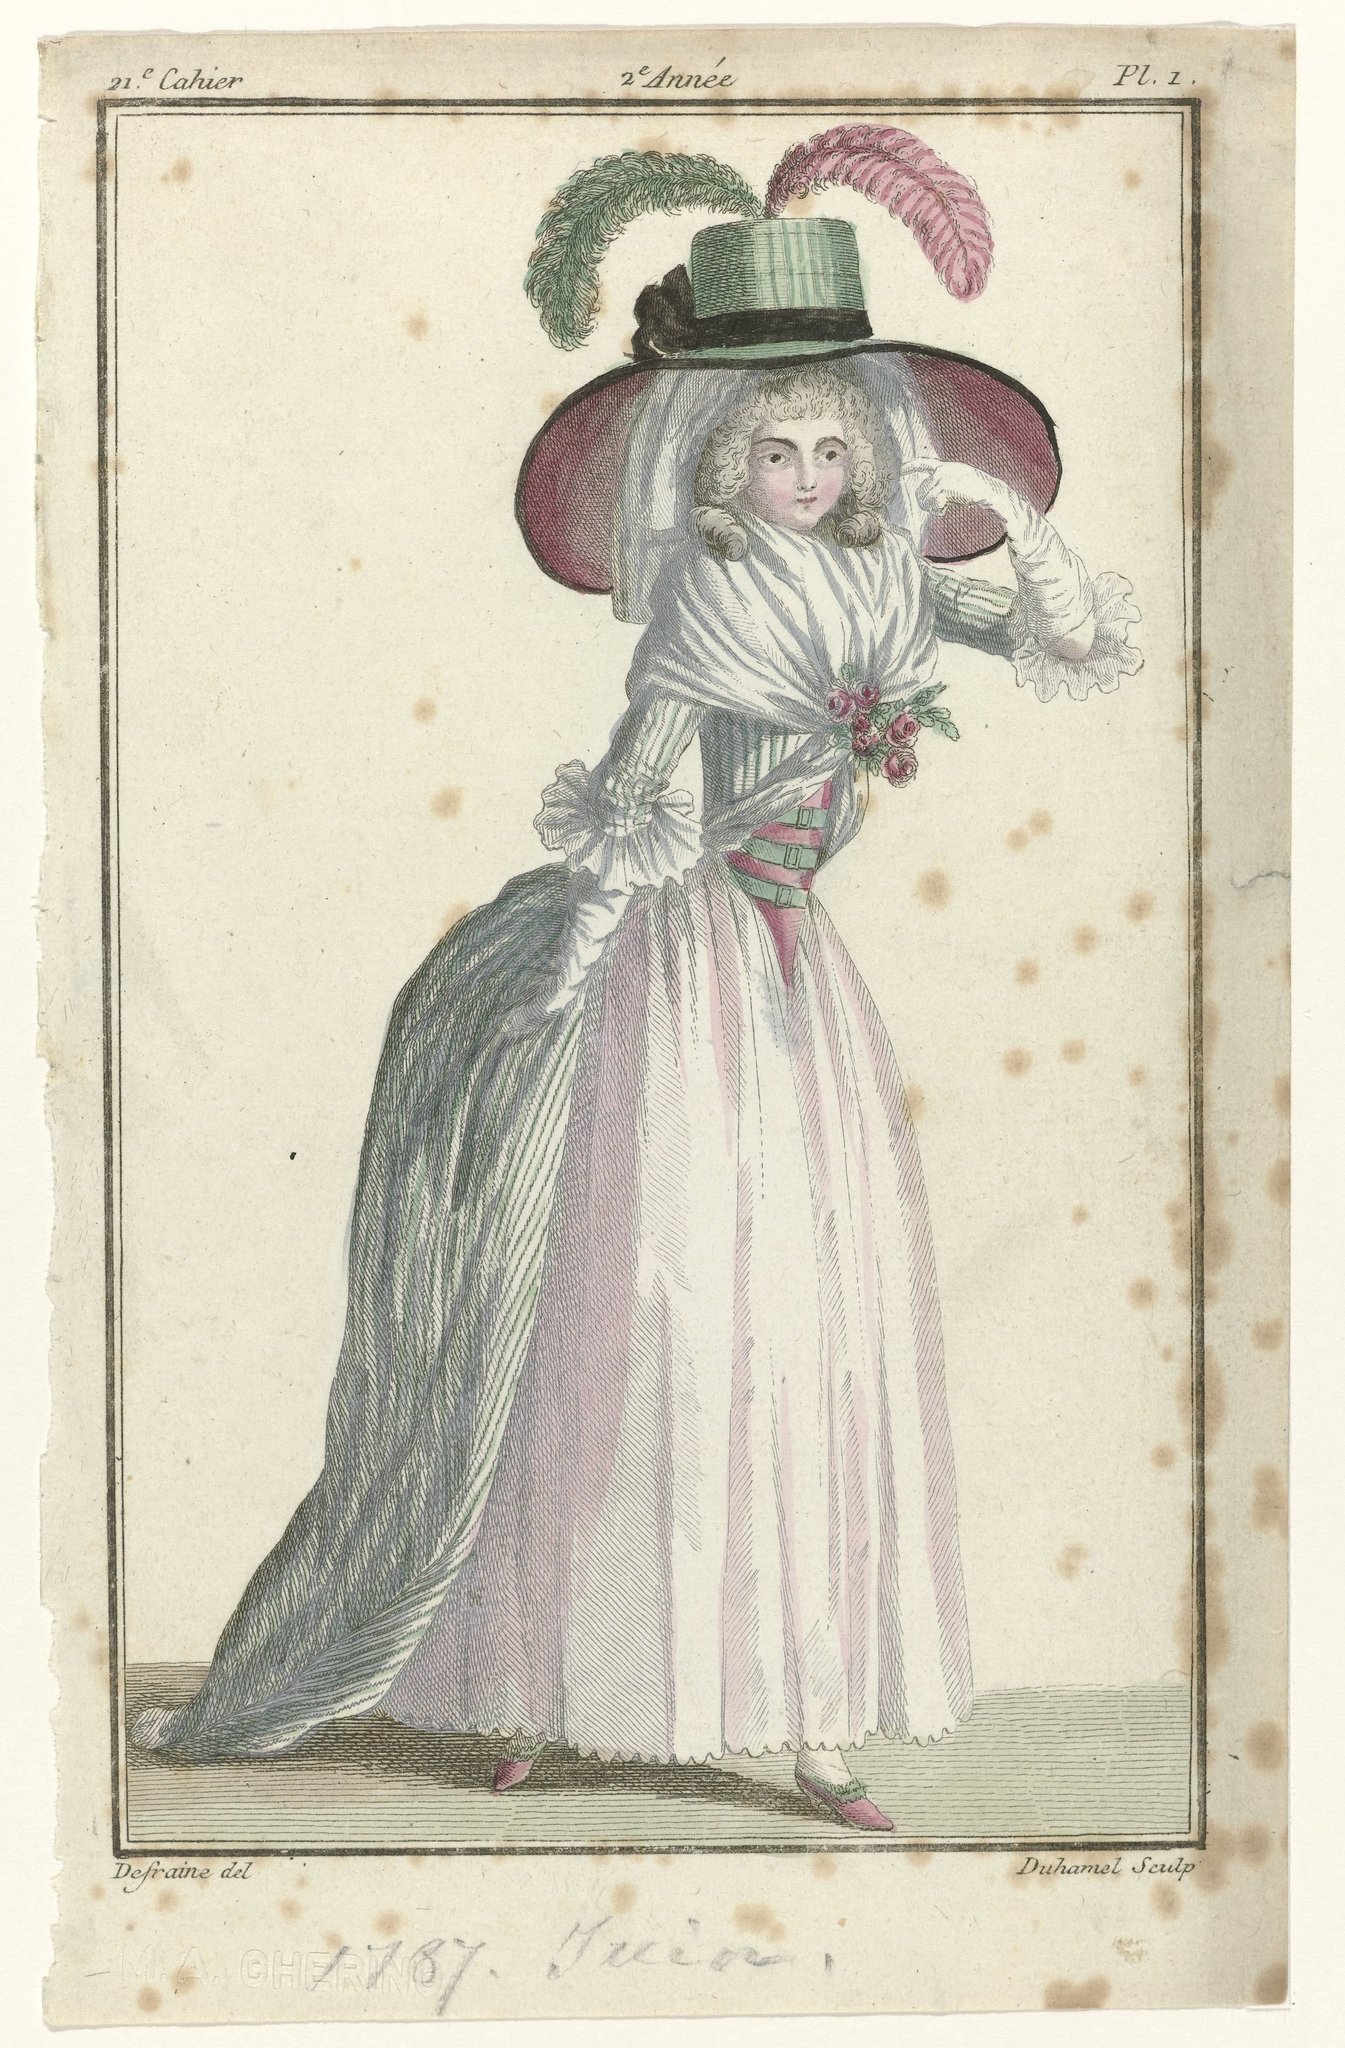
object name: fashion print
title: Magasin des Modes Nouvelles Françaises et Anglaises, 10 juin 1787, Pl. 1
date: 1787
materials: paper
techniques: engraving, hand coloring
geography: paris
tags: corsage (+ women's clothes), flowers, gloves, mittens (long gloves) (+ women's clothes), head-gear: cap (+ women's clothes), fashion plates, shoes, sandals (+ women's clothes), skirt (+ women's clothes), dress, gown (+ women's clothes), piece of clothing covering the breast or décolleté (fichu) (+ women's clothes)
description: Lopende vrouw naar rechts, gekleed in een gestreepte japon met sleep. Hieronder draagt zij een puntig lijfje, rok met geschulpte zoom en kousen. De fichu is voor gekruist en op de rug vastgemaakt. Accessoires: grote hoed van vilt met twee veren, bloemcorsage, lange handschoenen, schoenen met hakken. De prent maakt deel uit van het 21e Cahier, 2e année, uit de serie Magasin des Modes Nouvelles Françaises et Anglaises. De serie bestaat uit 172 modeprenten, uitgegeven door Buisson, Parijs, 20 november 1786 - 21 décembre 1789.